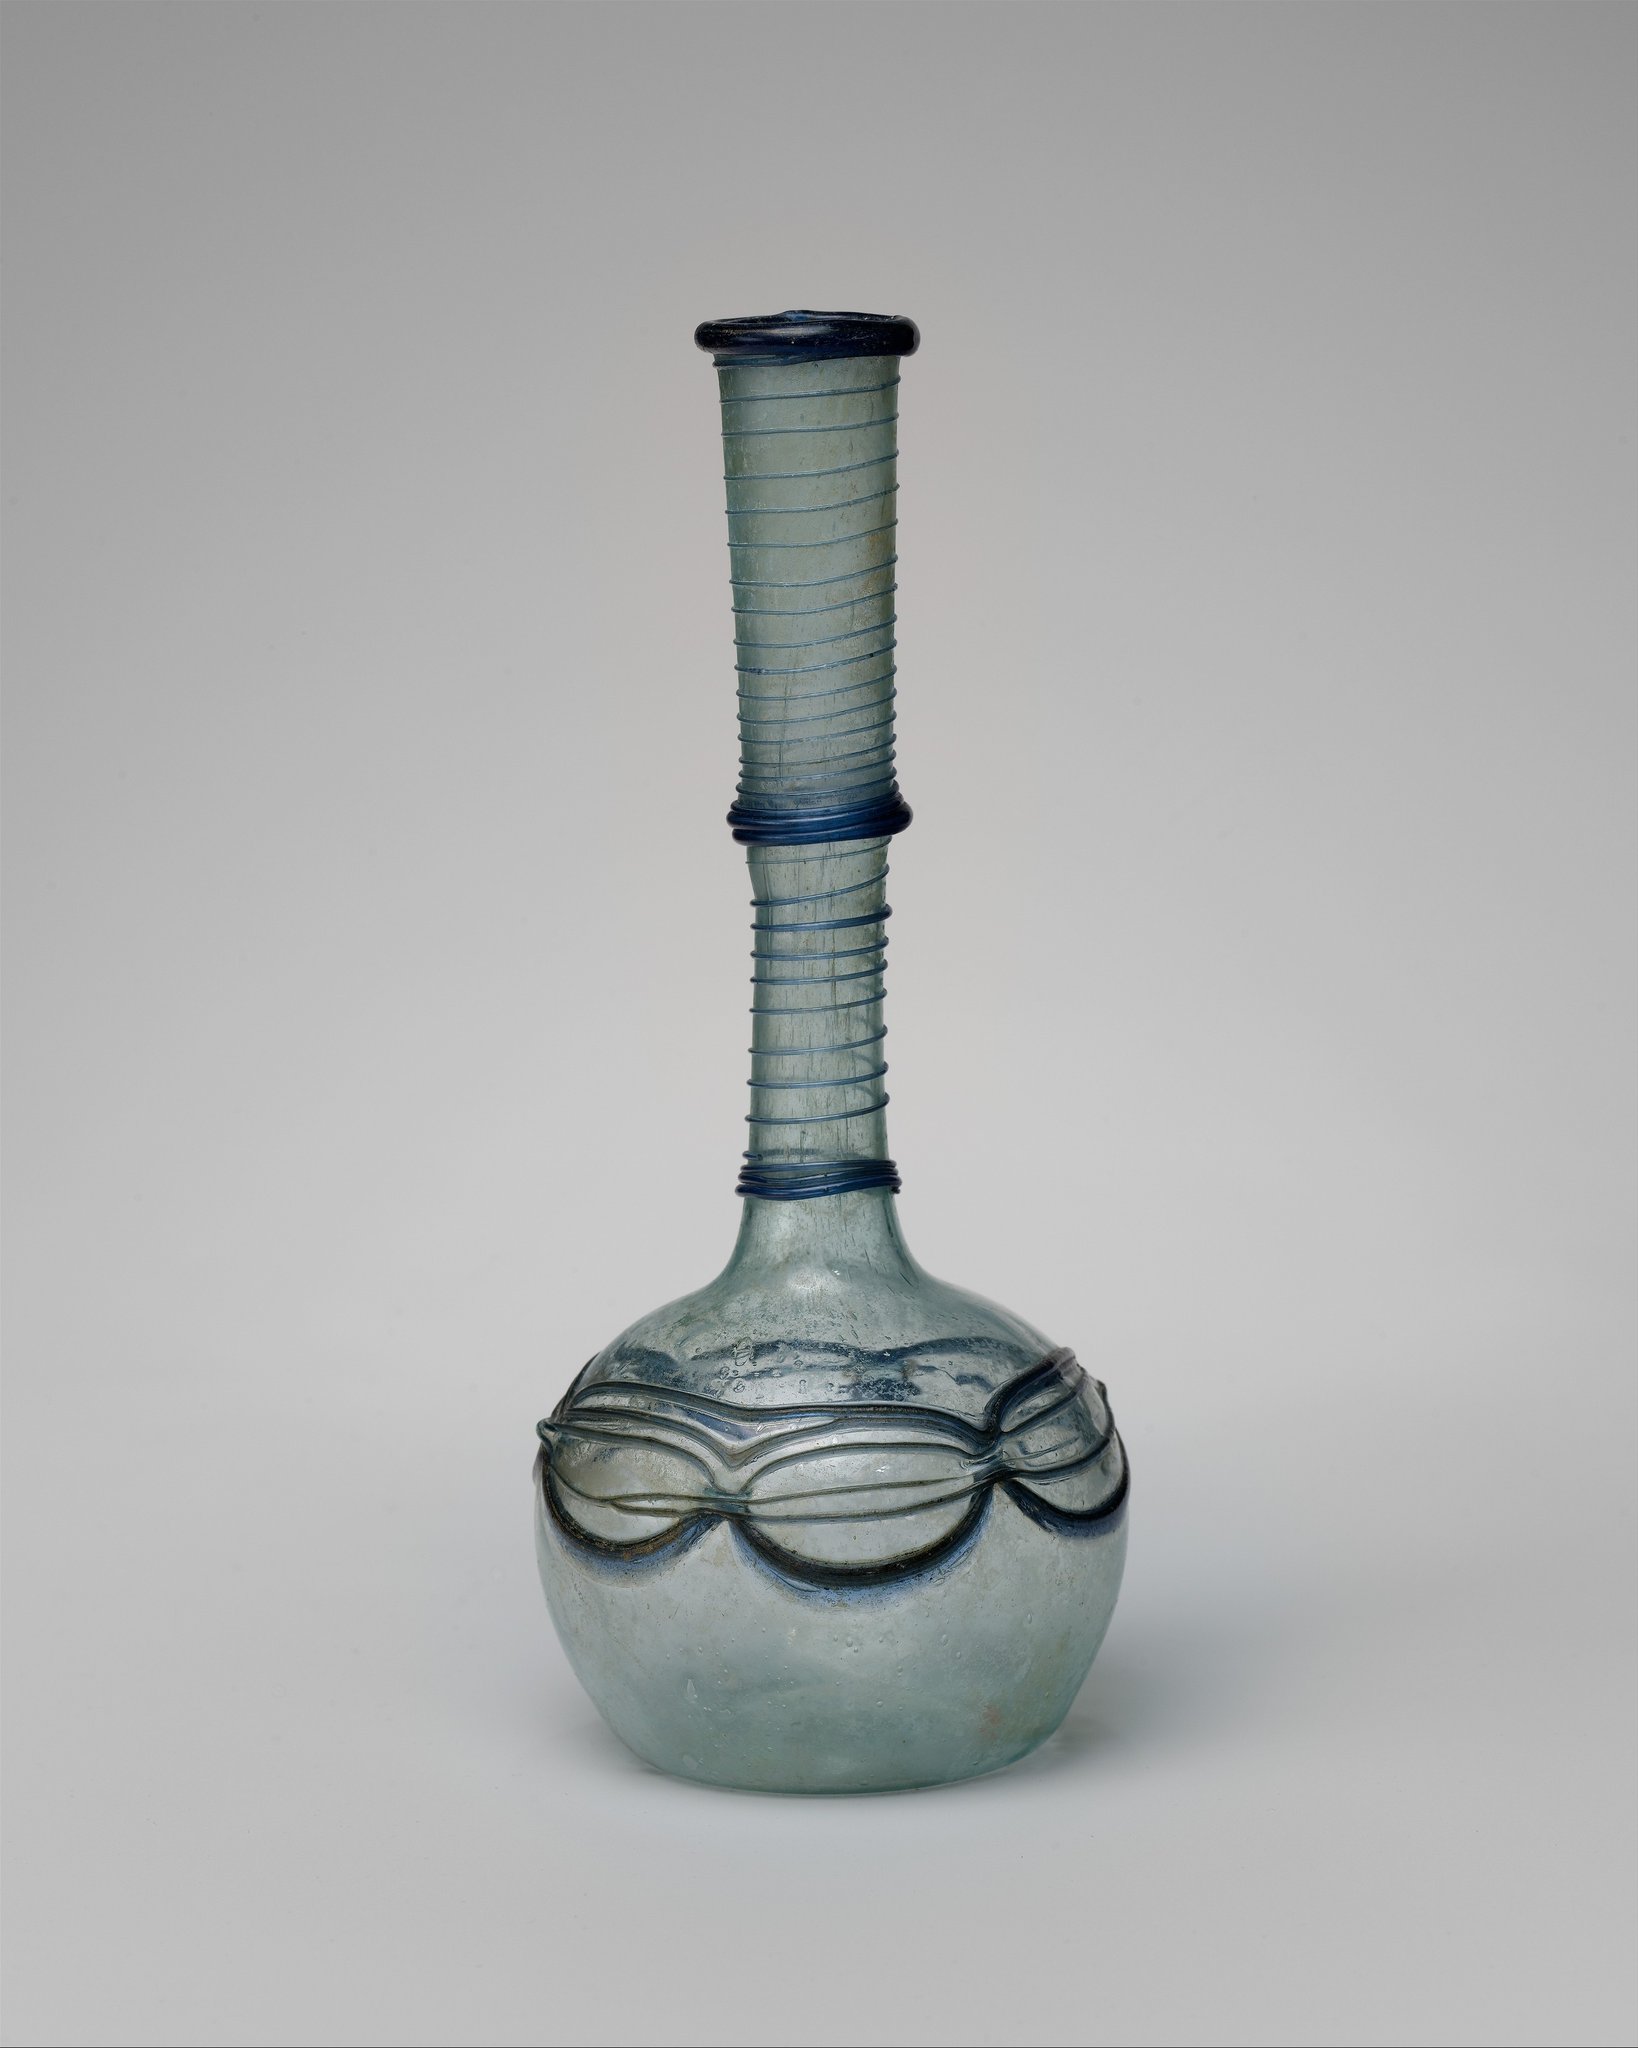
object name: bottle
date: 601-733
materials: glass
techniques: glassblowing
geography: egypt or syria